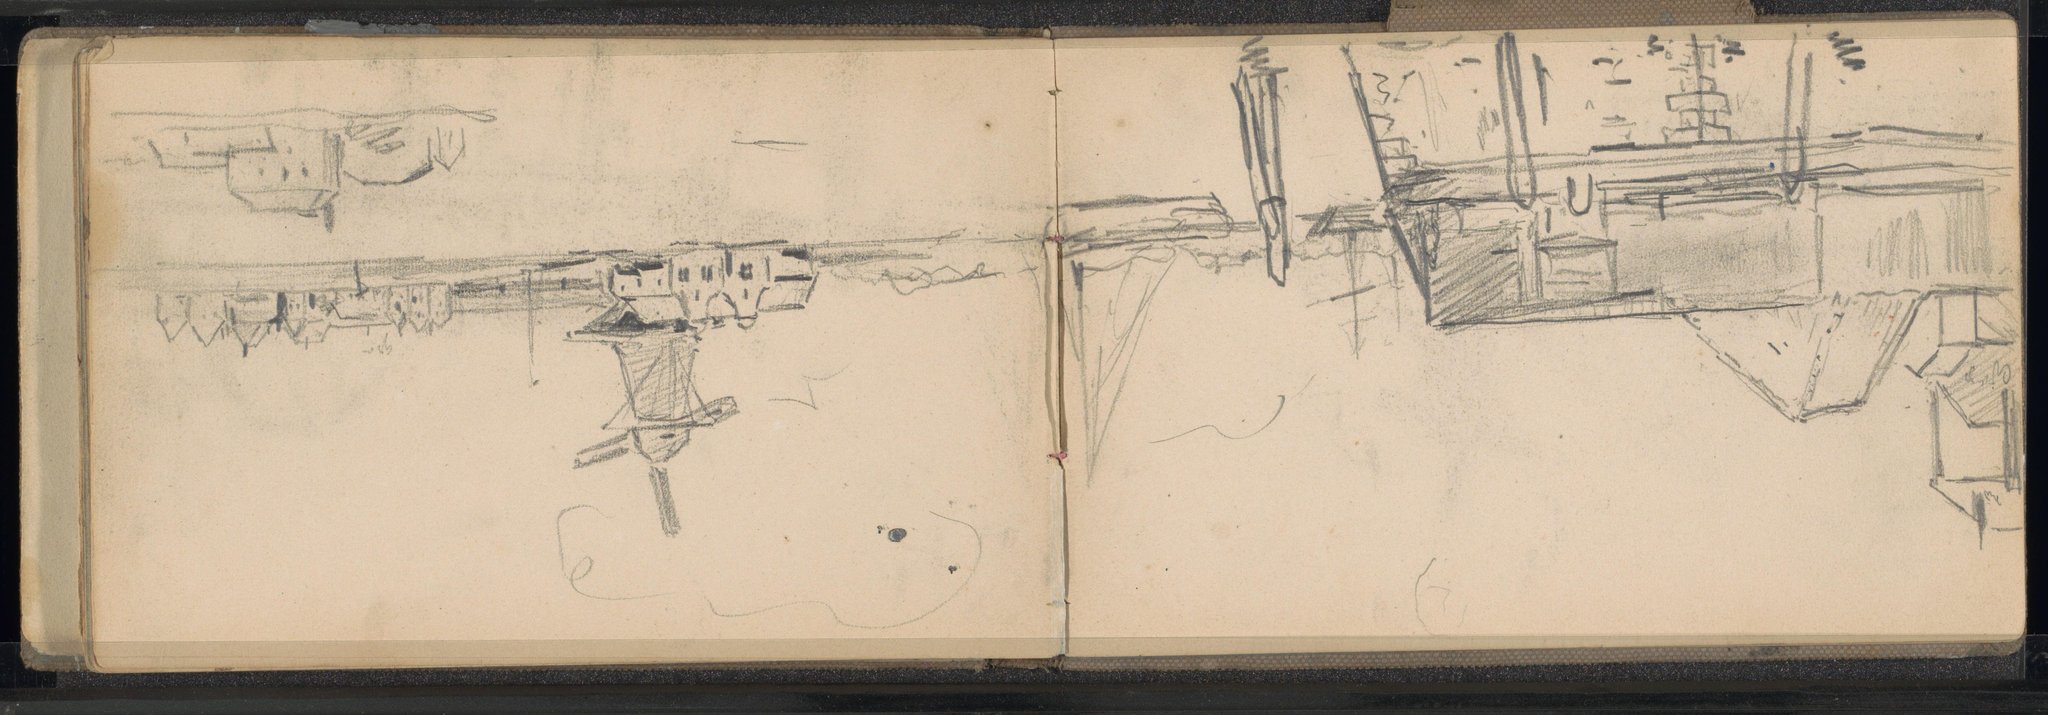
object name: sketchbook leaf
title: Stad aan een rivier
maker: louis apol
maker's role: draughtsman, painter, print maker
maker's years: 1850-1936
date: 1880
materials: paper, pencil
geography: south holland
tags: city-view, and landscape with man-made constructions, river, windmill in landscape (+ city(-scape) with figures, staffage)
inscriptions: kleurnotitie, handgeschreven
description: Op de andere oever een molen. Blad 33 verso en blad 34 recto uit een schetsboek met 38 bladen betekend tijdens de expeditie naar Nova Zembla in 1880.